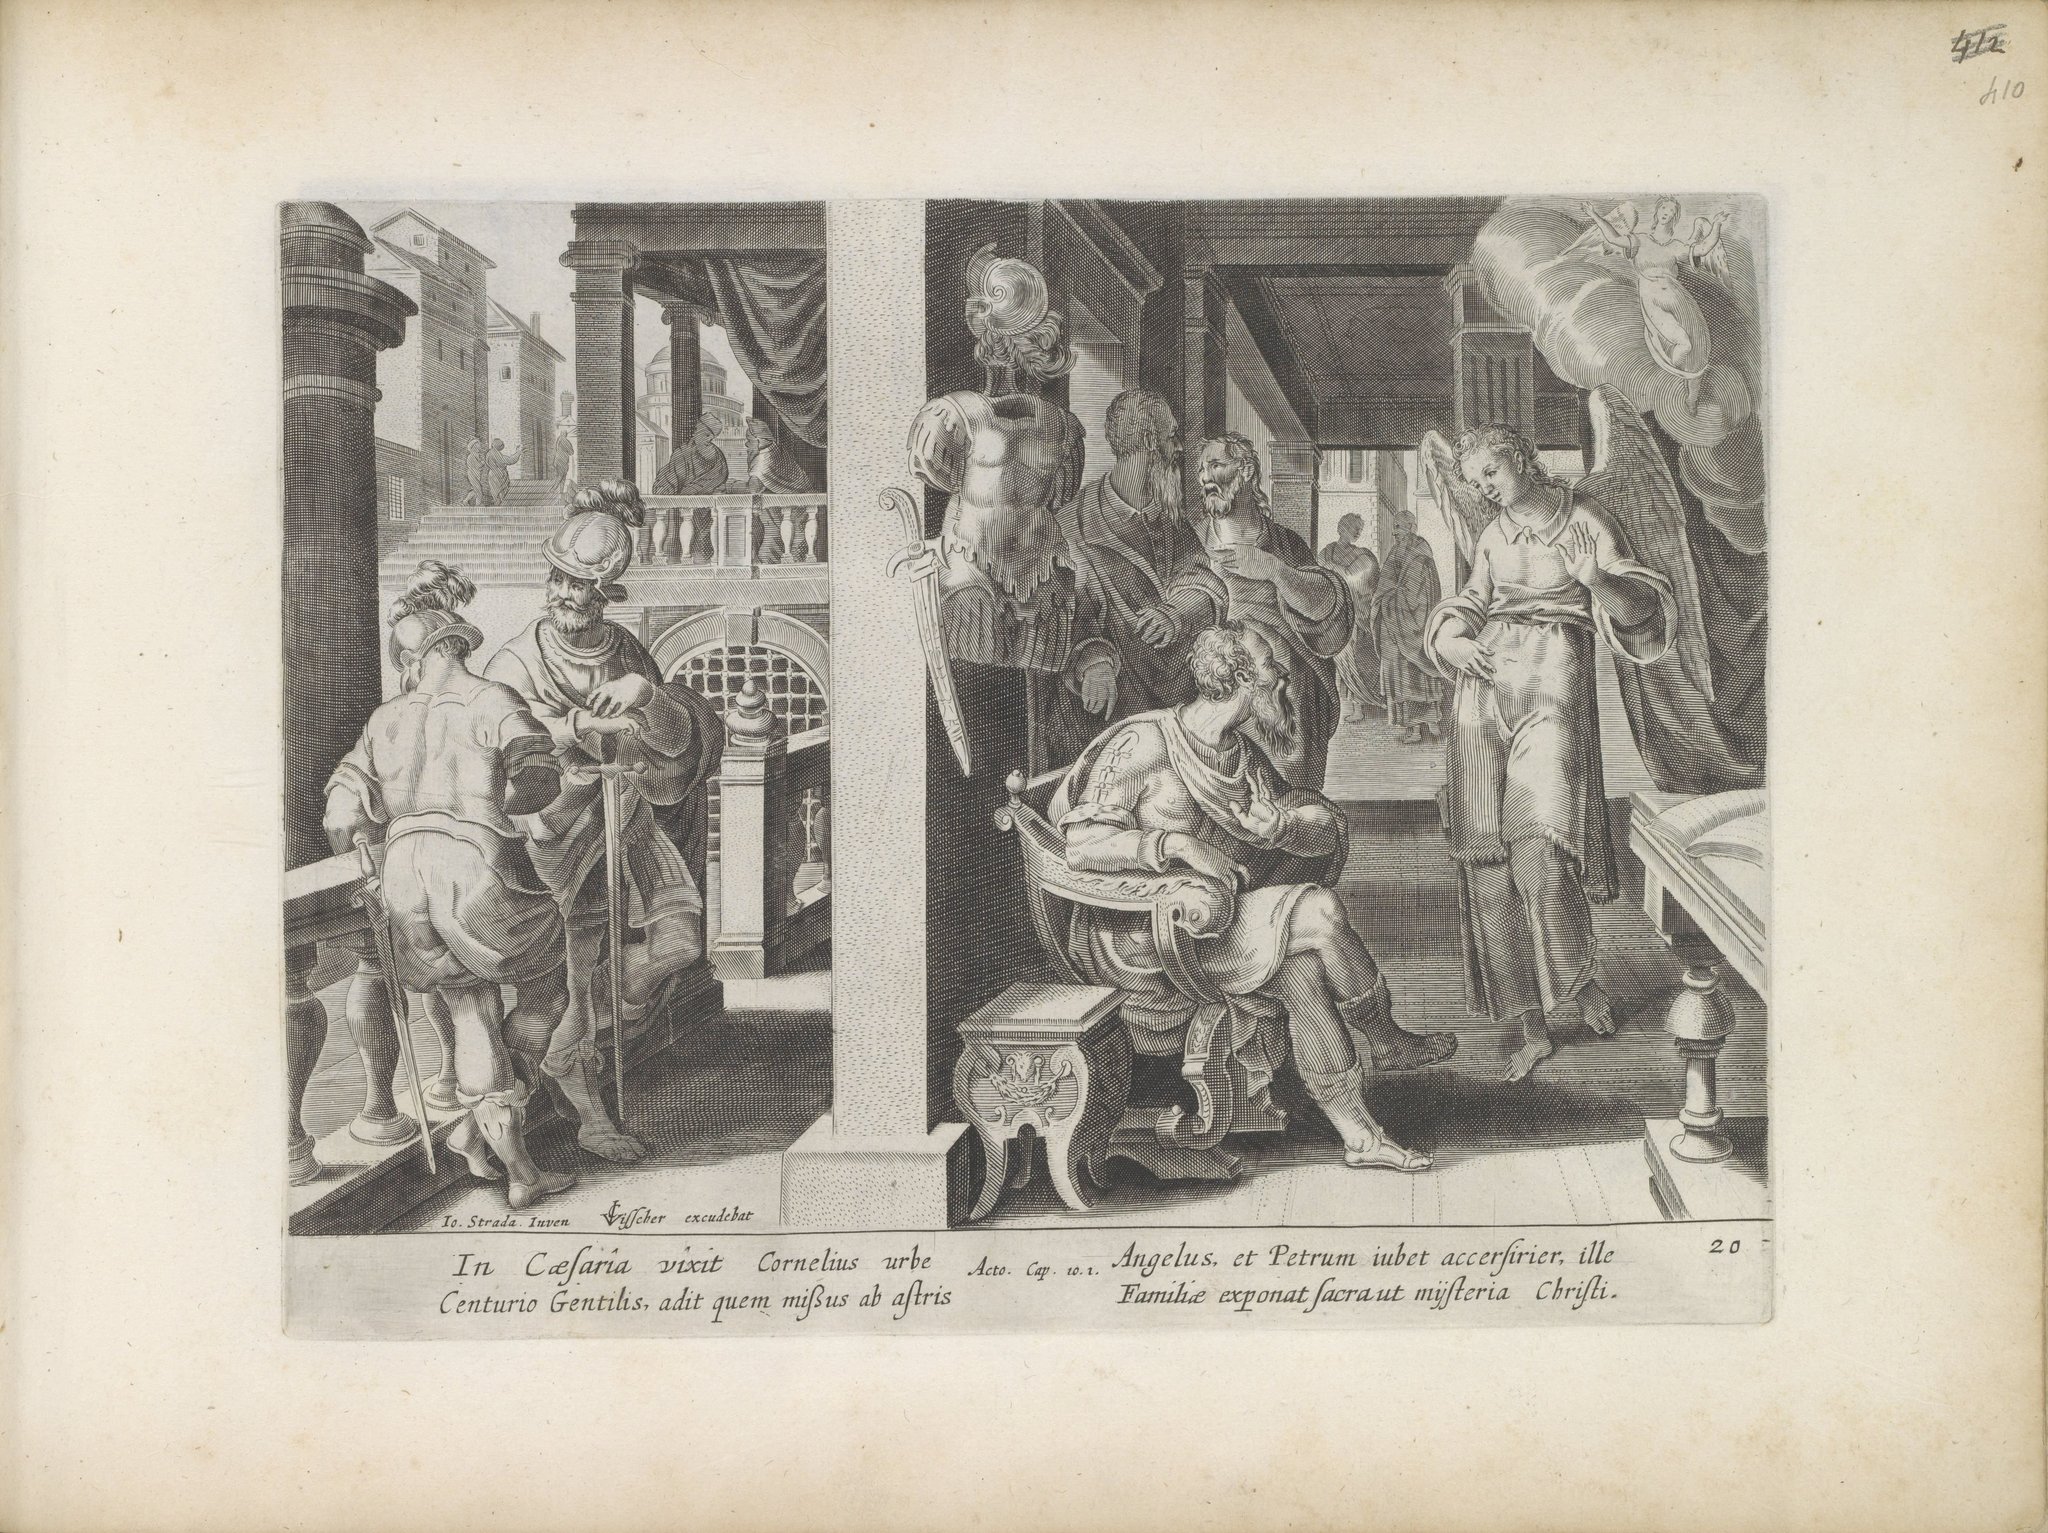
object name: album leaf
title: Visioen van Cornelius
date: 1643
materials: paper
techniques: engraving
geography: amsterdam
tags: cornelius sends two servants and a soldier to peter in joppa, cornelius the centurion and the angel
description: Een engel verschijnt voor Cornelius in een visioen. Hij beveelt hem de apostel Petrus uit Joppe te laten halen. Twee soldaten worden eropuit gestuurd om Petrus te halen. Onder de voorstelling een verwijzing in het Latijn naar de Bijbeltekst in Hand. 10:1. Deze prent maakt deel uit van een album.